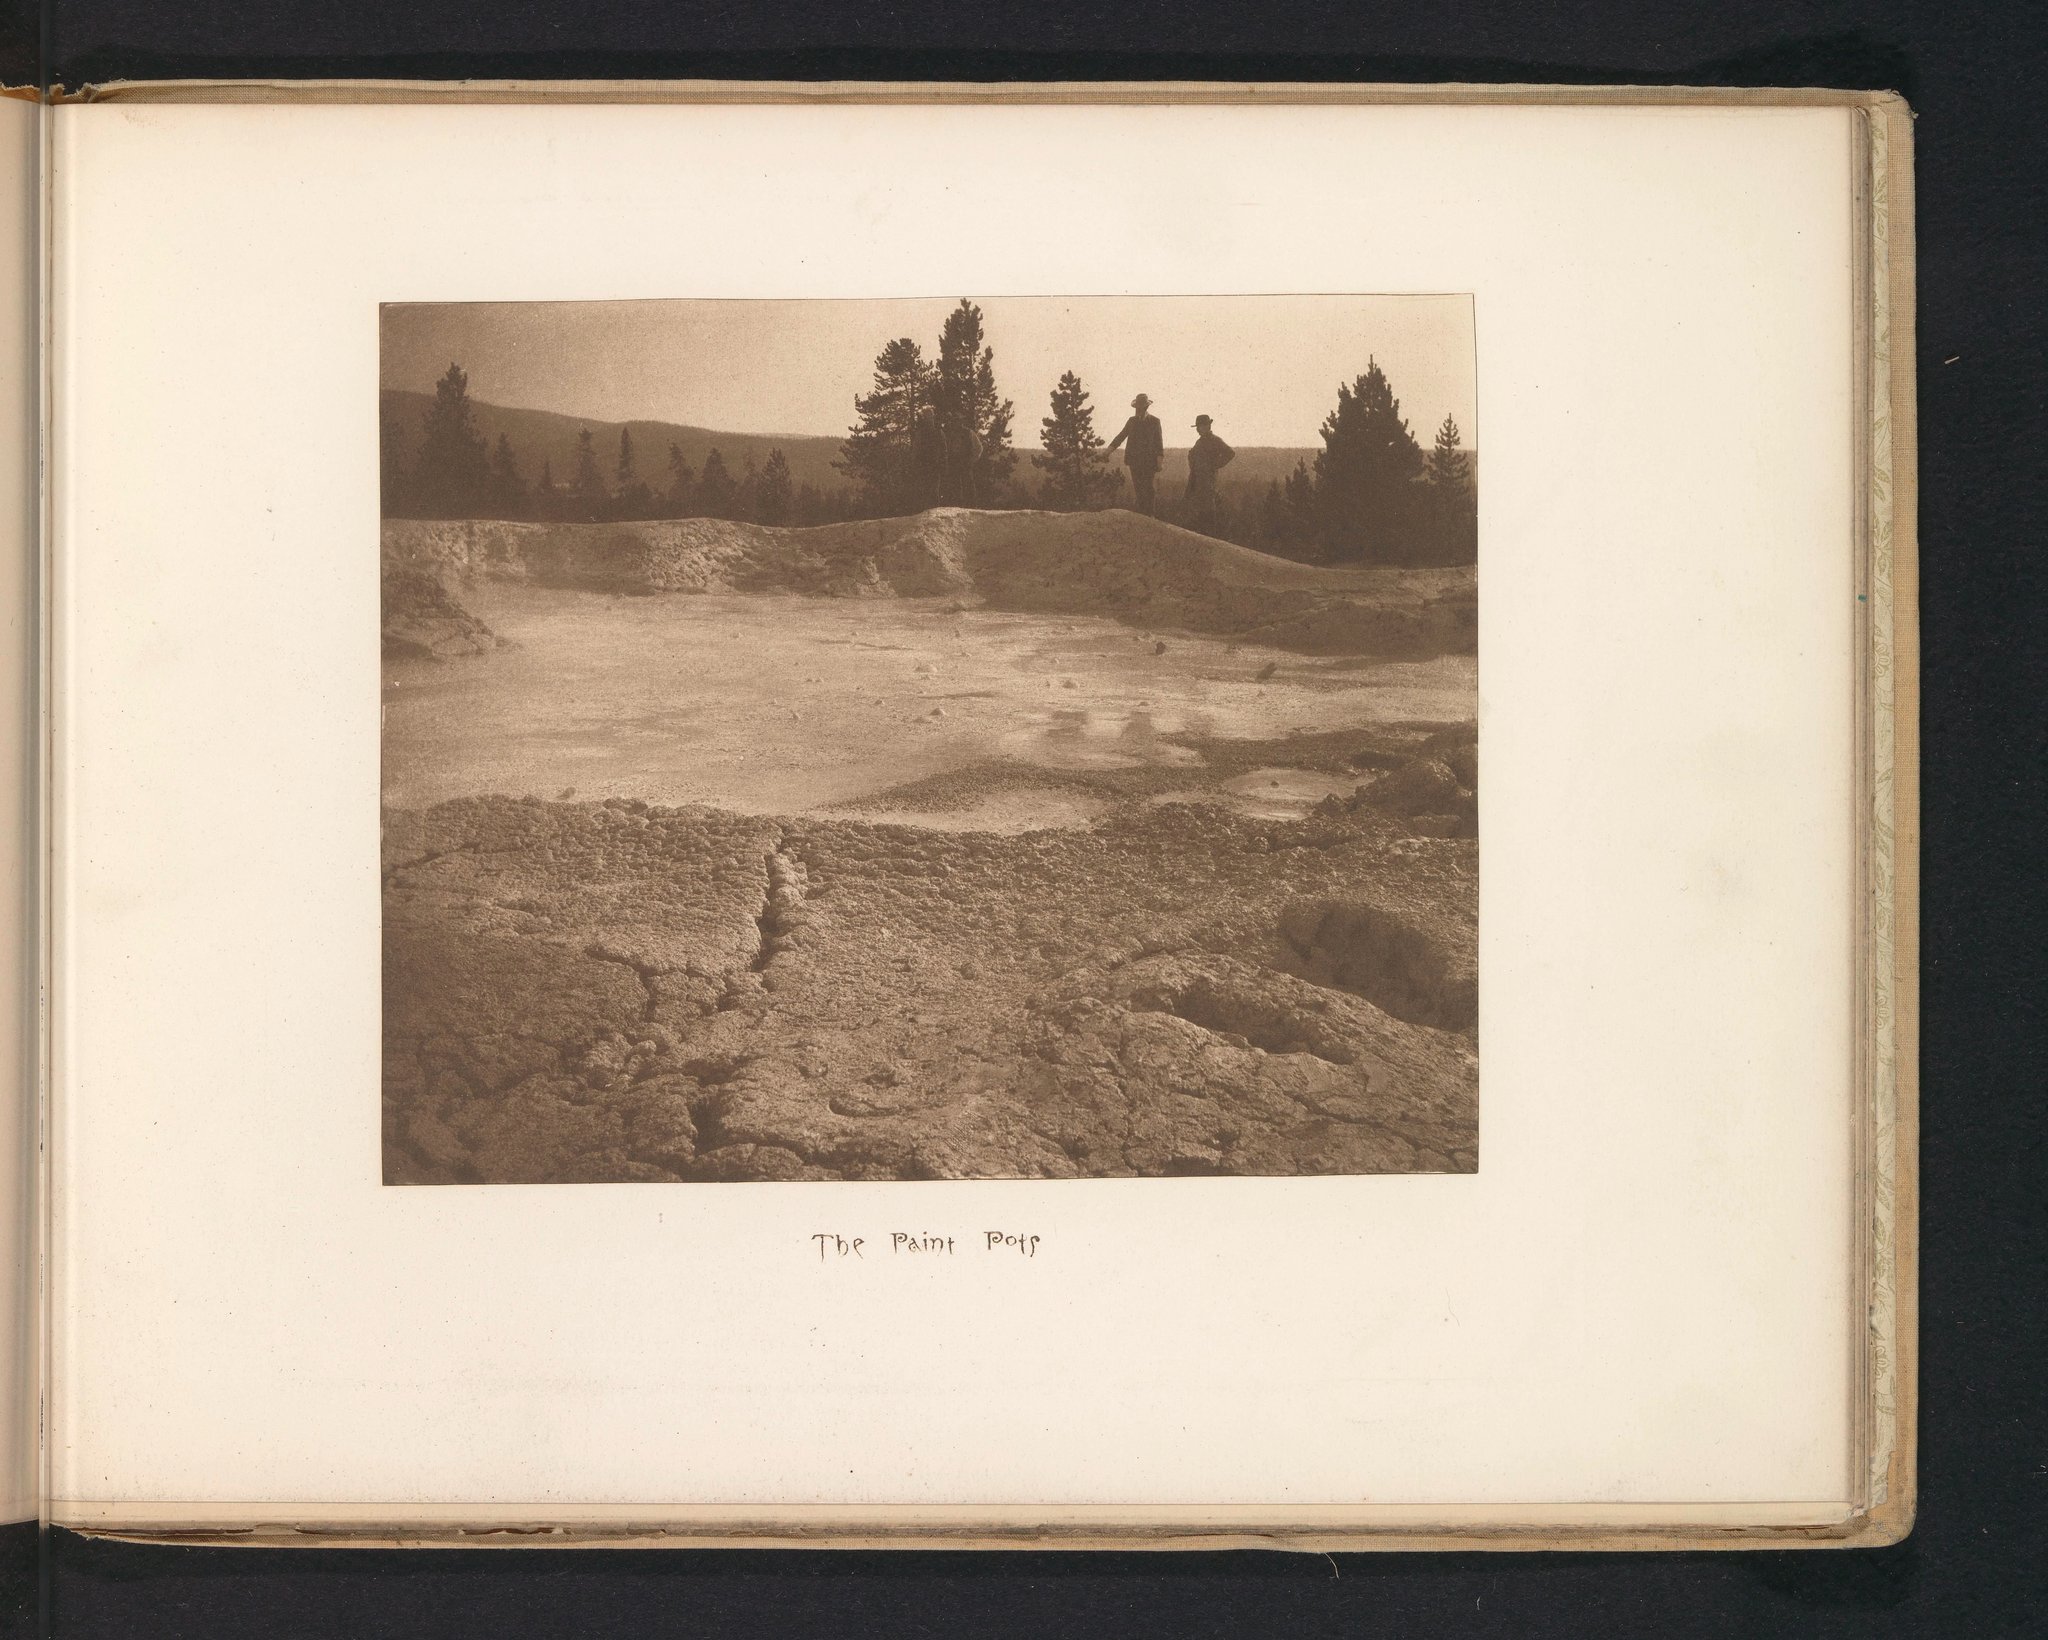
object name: photomechanical print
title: The paint pots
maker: frank jay haynes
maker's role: fotograaf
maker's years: 1853-1921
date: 1882-1887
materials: paper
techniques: photoaquatint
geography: new york city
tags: hot spring, geyser, pond, pool